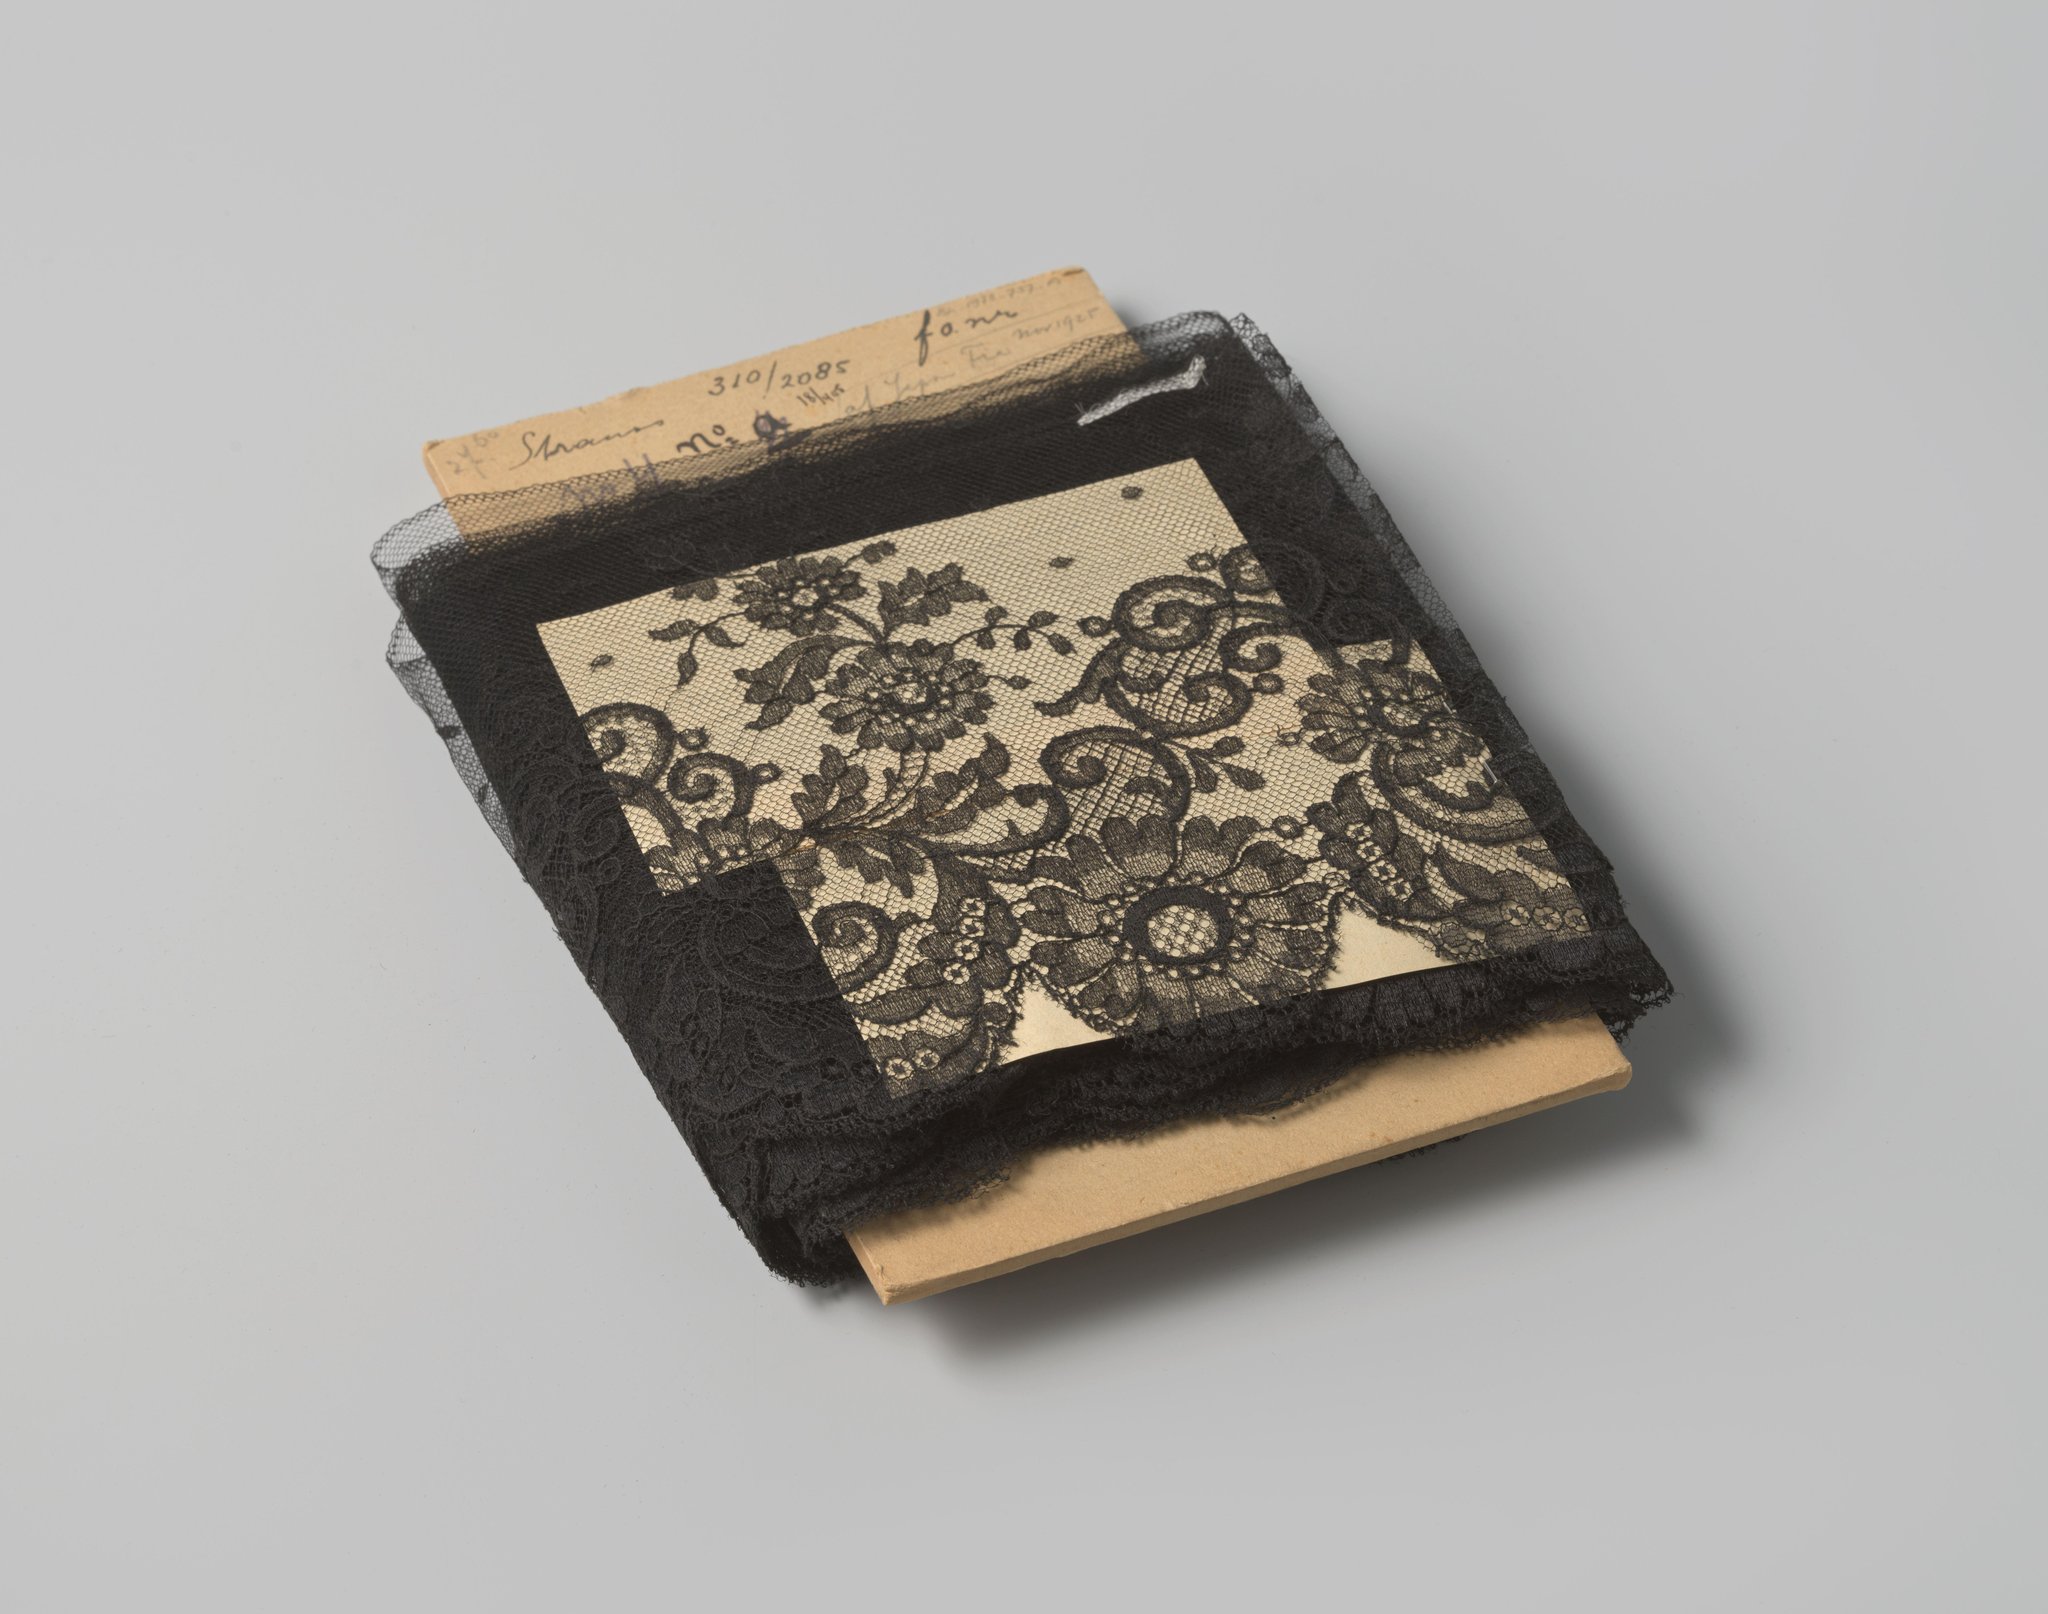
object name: braid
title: Strook zwarte machinale tule met schulpen aan één zijde en een ondulerend motief van bloemen en voluten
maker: gustav schnitzler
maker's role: paraplufabrikant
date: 1925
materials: fiber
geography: nijmegen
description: Strook zwarte machinale tule met schulpen aan één zijde en een ondulerend motief van bloemen en voluten, op zachtboard.